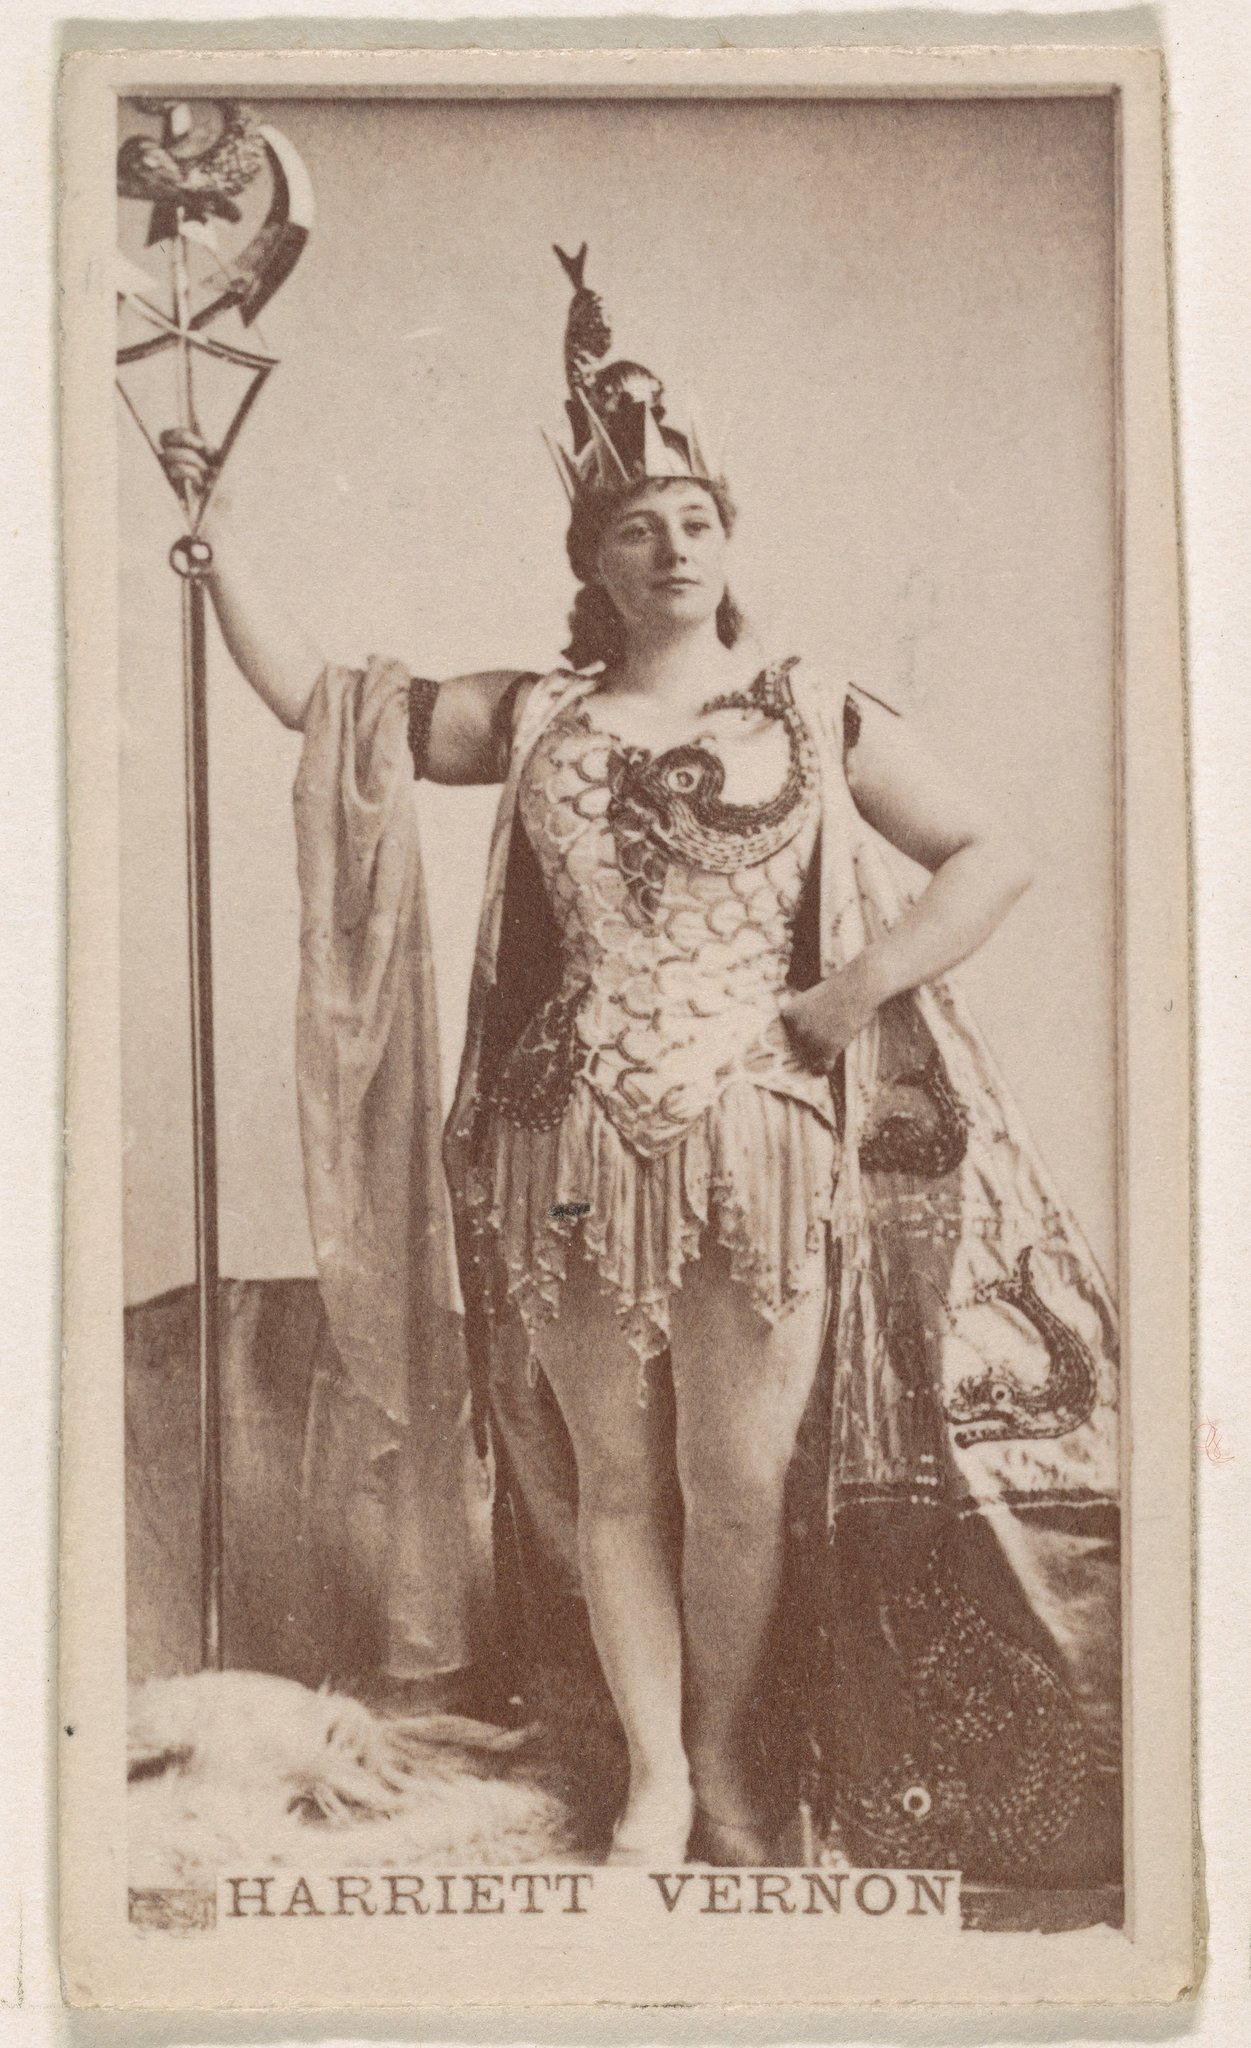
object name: photograph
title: Harriett Vernon, from the Actresses series (N245) issued by Kinney Brothers to promote Sweet Caporal Cigarettes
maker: kinney brothers tobacco company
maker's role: publisher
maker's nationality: american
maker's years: 1869-2011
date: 1890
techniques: albumen silver print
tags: portraits,women,actresses